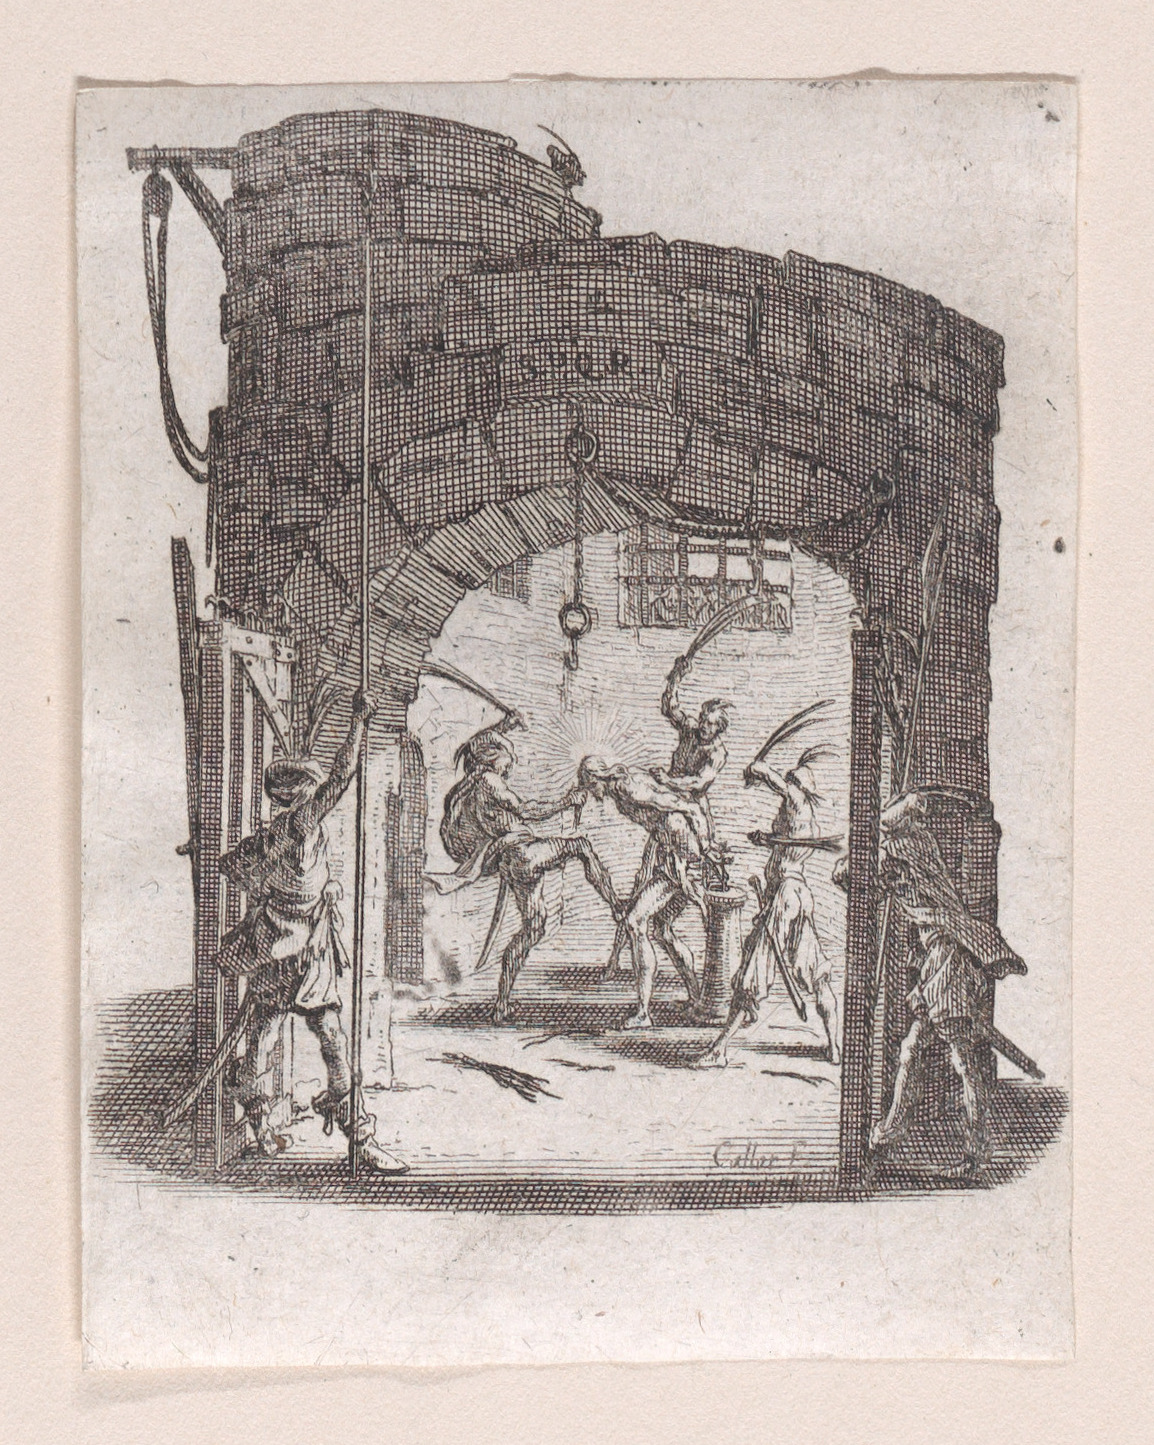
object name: print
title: Jésus est Battu de Verges pièce appelée aussi La Flagellation (The Flagellation), from "La Petite Passion" (The Little Passion)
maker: jacques callot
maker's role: artist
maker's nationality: french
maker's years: 1592-1635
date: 1624-1625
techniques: etching